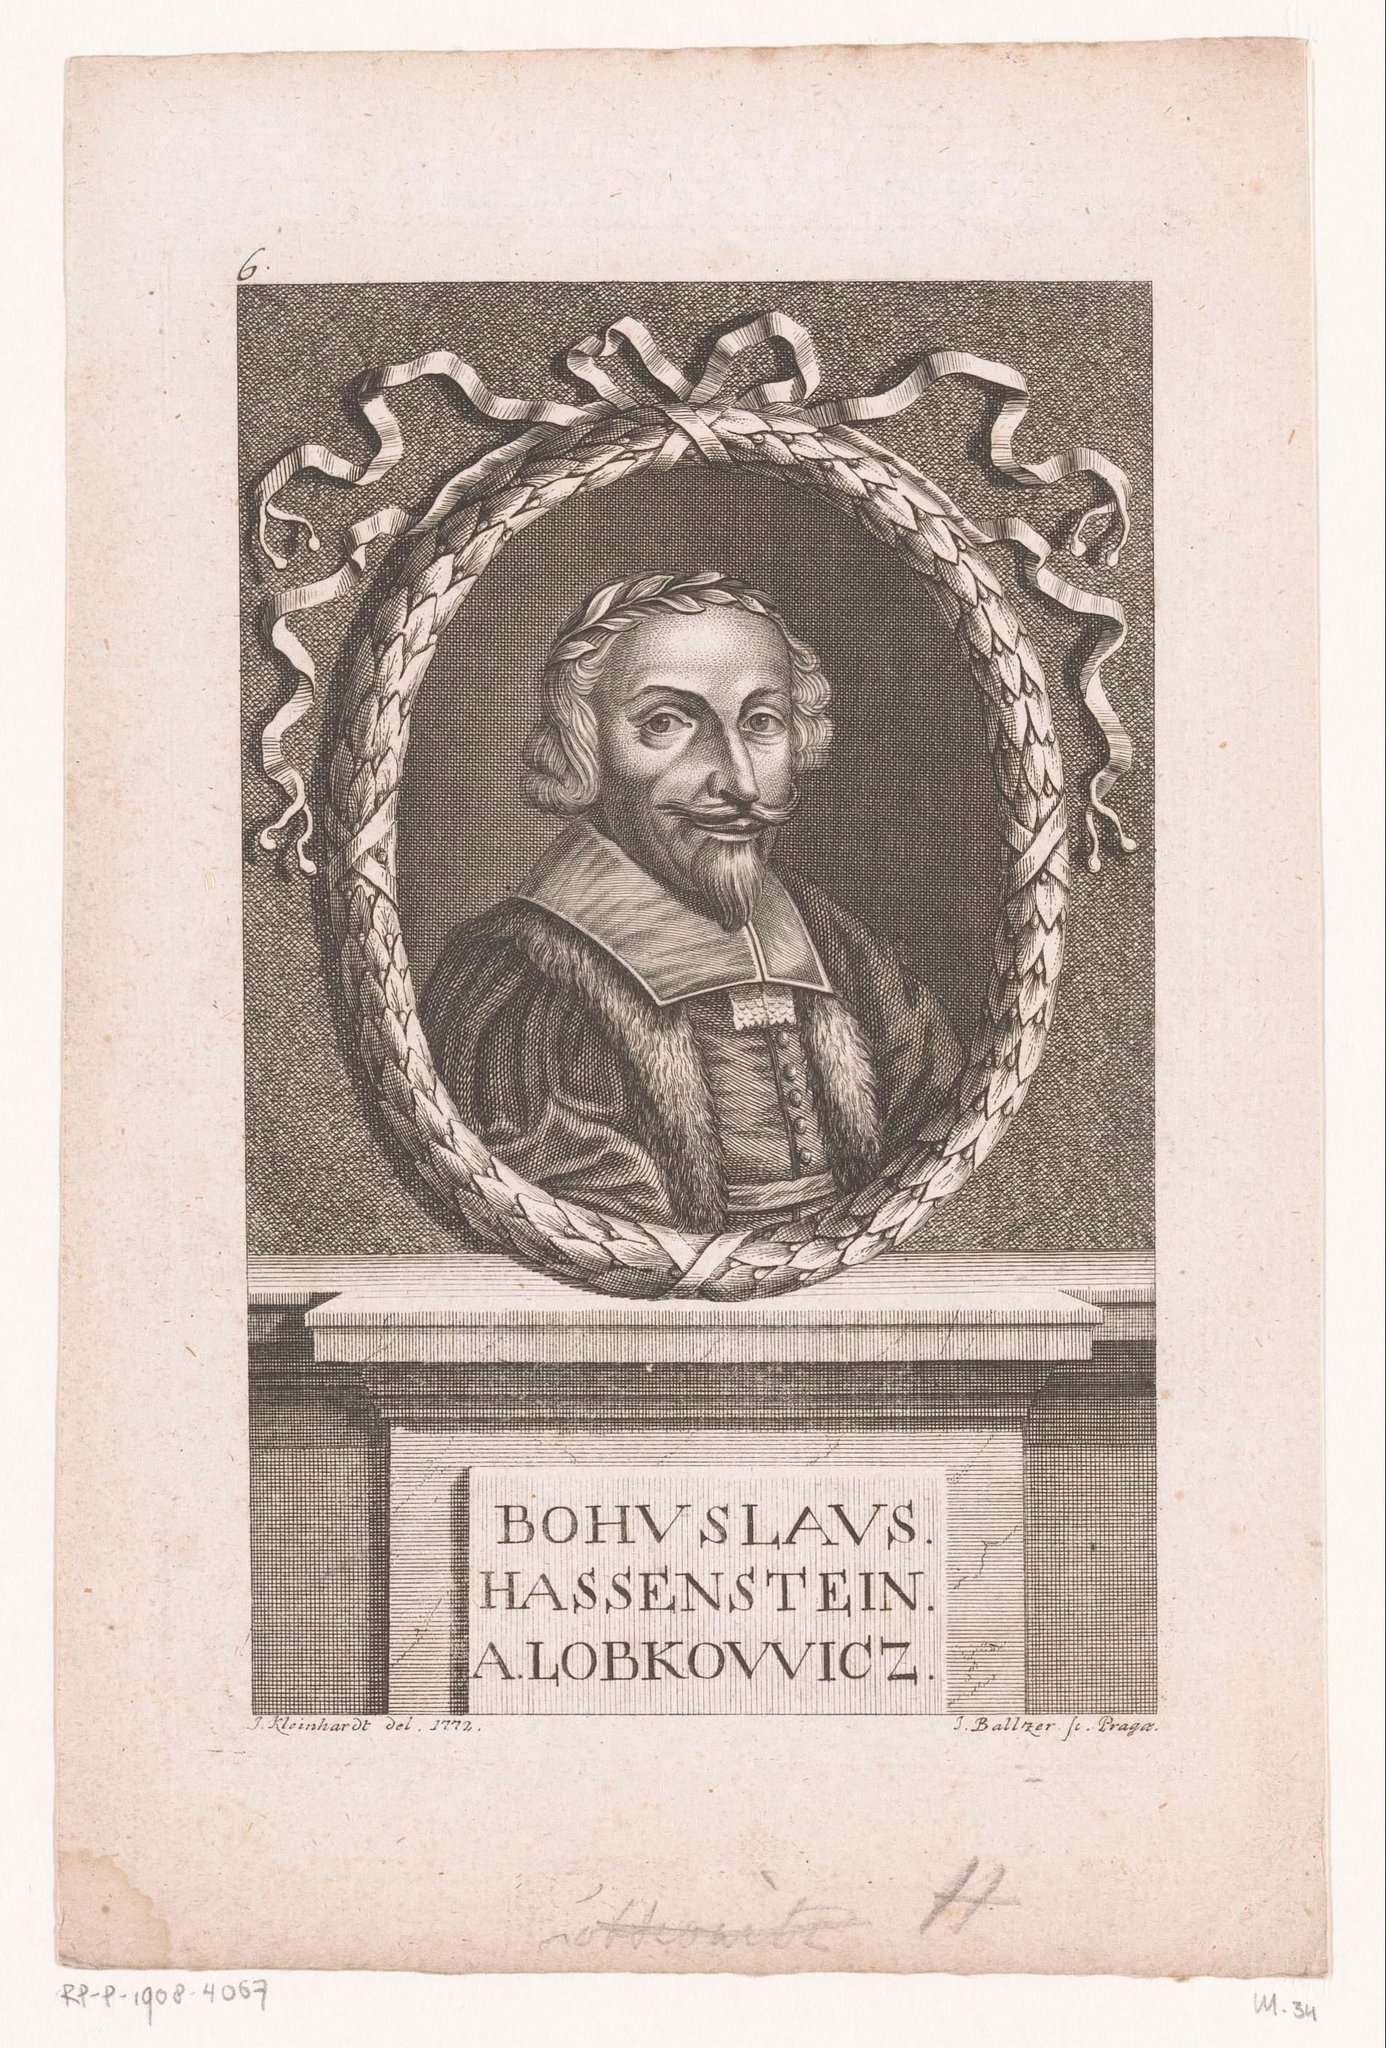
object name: print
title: Portret van Bohuslaw Lobkowitz von Hassenstein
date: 1772-1799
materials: paper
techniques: engraving, etching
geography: prague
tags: historical persons, writer, poet, author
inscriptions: collector's mark: Lugt 2228